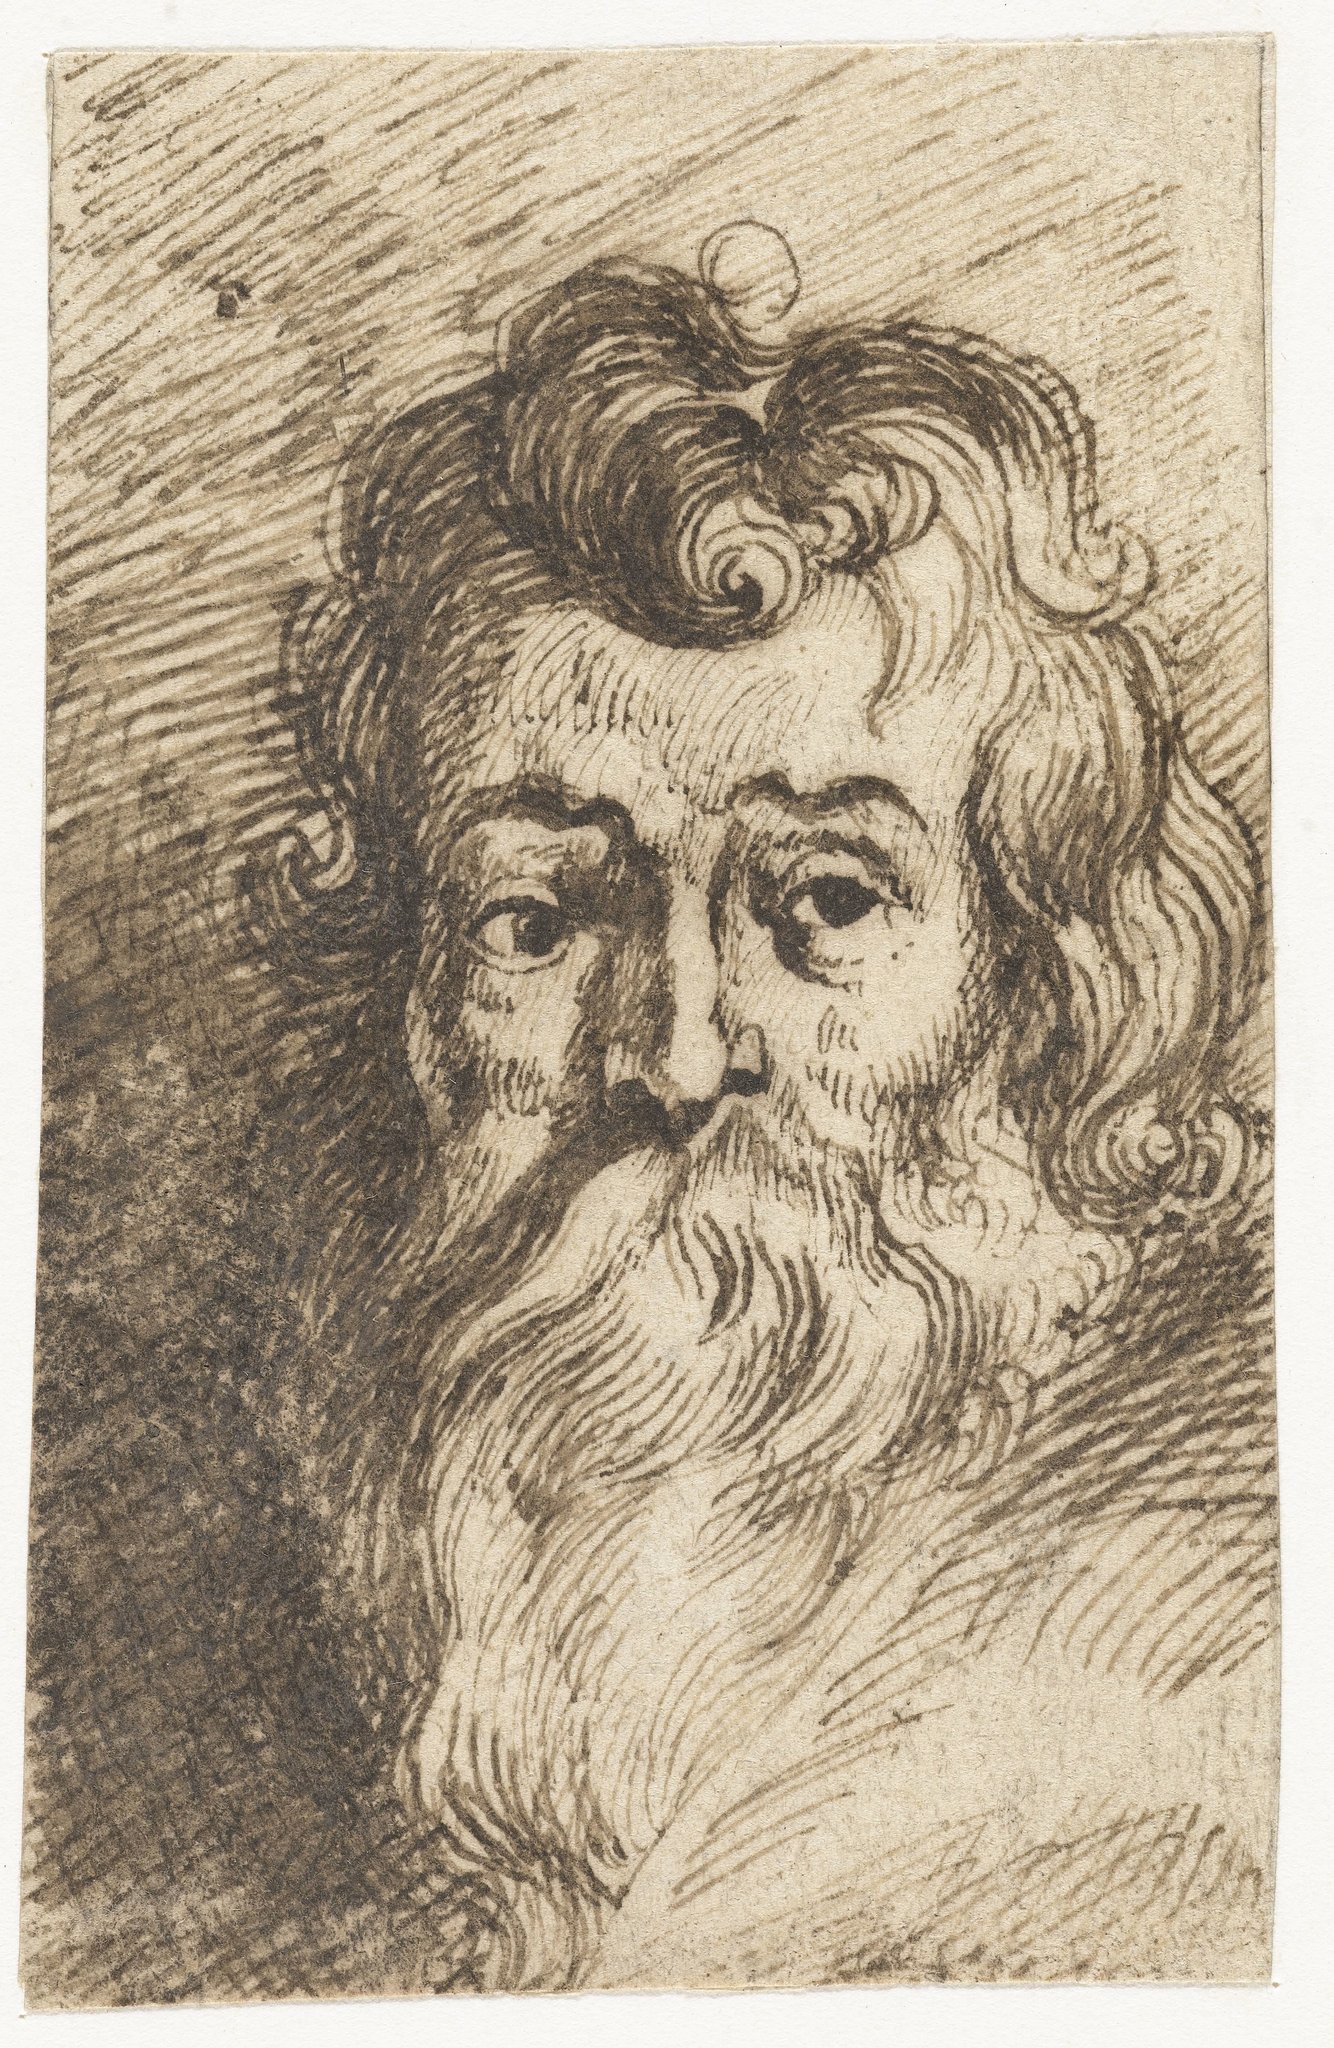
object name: drawing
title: Manshoofd met lange baard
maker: peter paul rubens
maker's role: draughtsman, painter, print maker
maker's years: 1577-1640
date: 1587-1640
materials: ink, paper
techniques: pen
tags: head (human), male sex; man